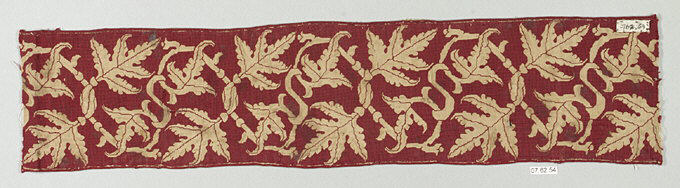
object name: band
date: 1601-1700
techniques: embroidery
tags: leaves